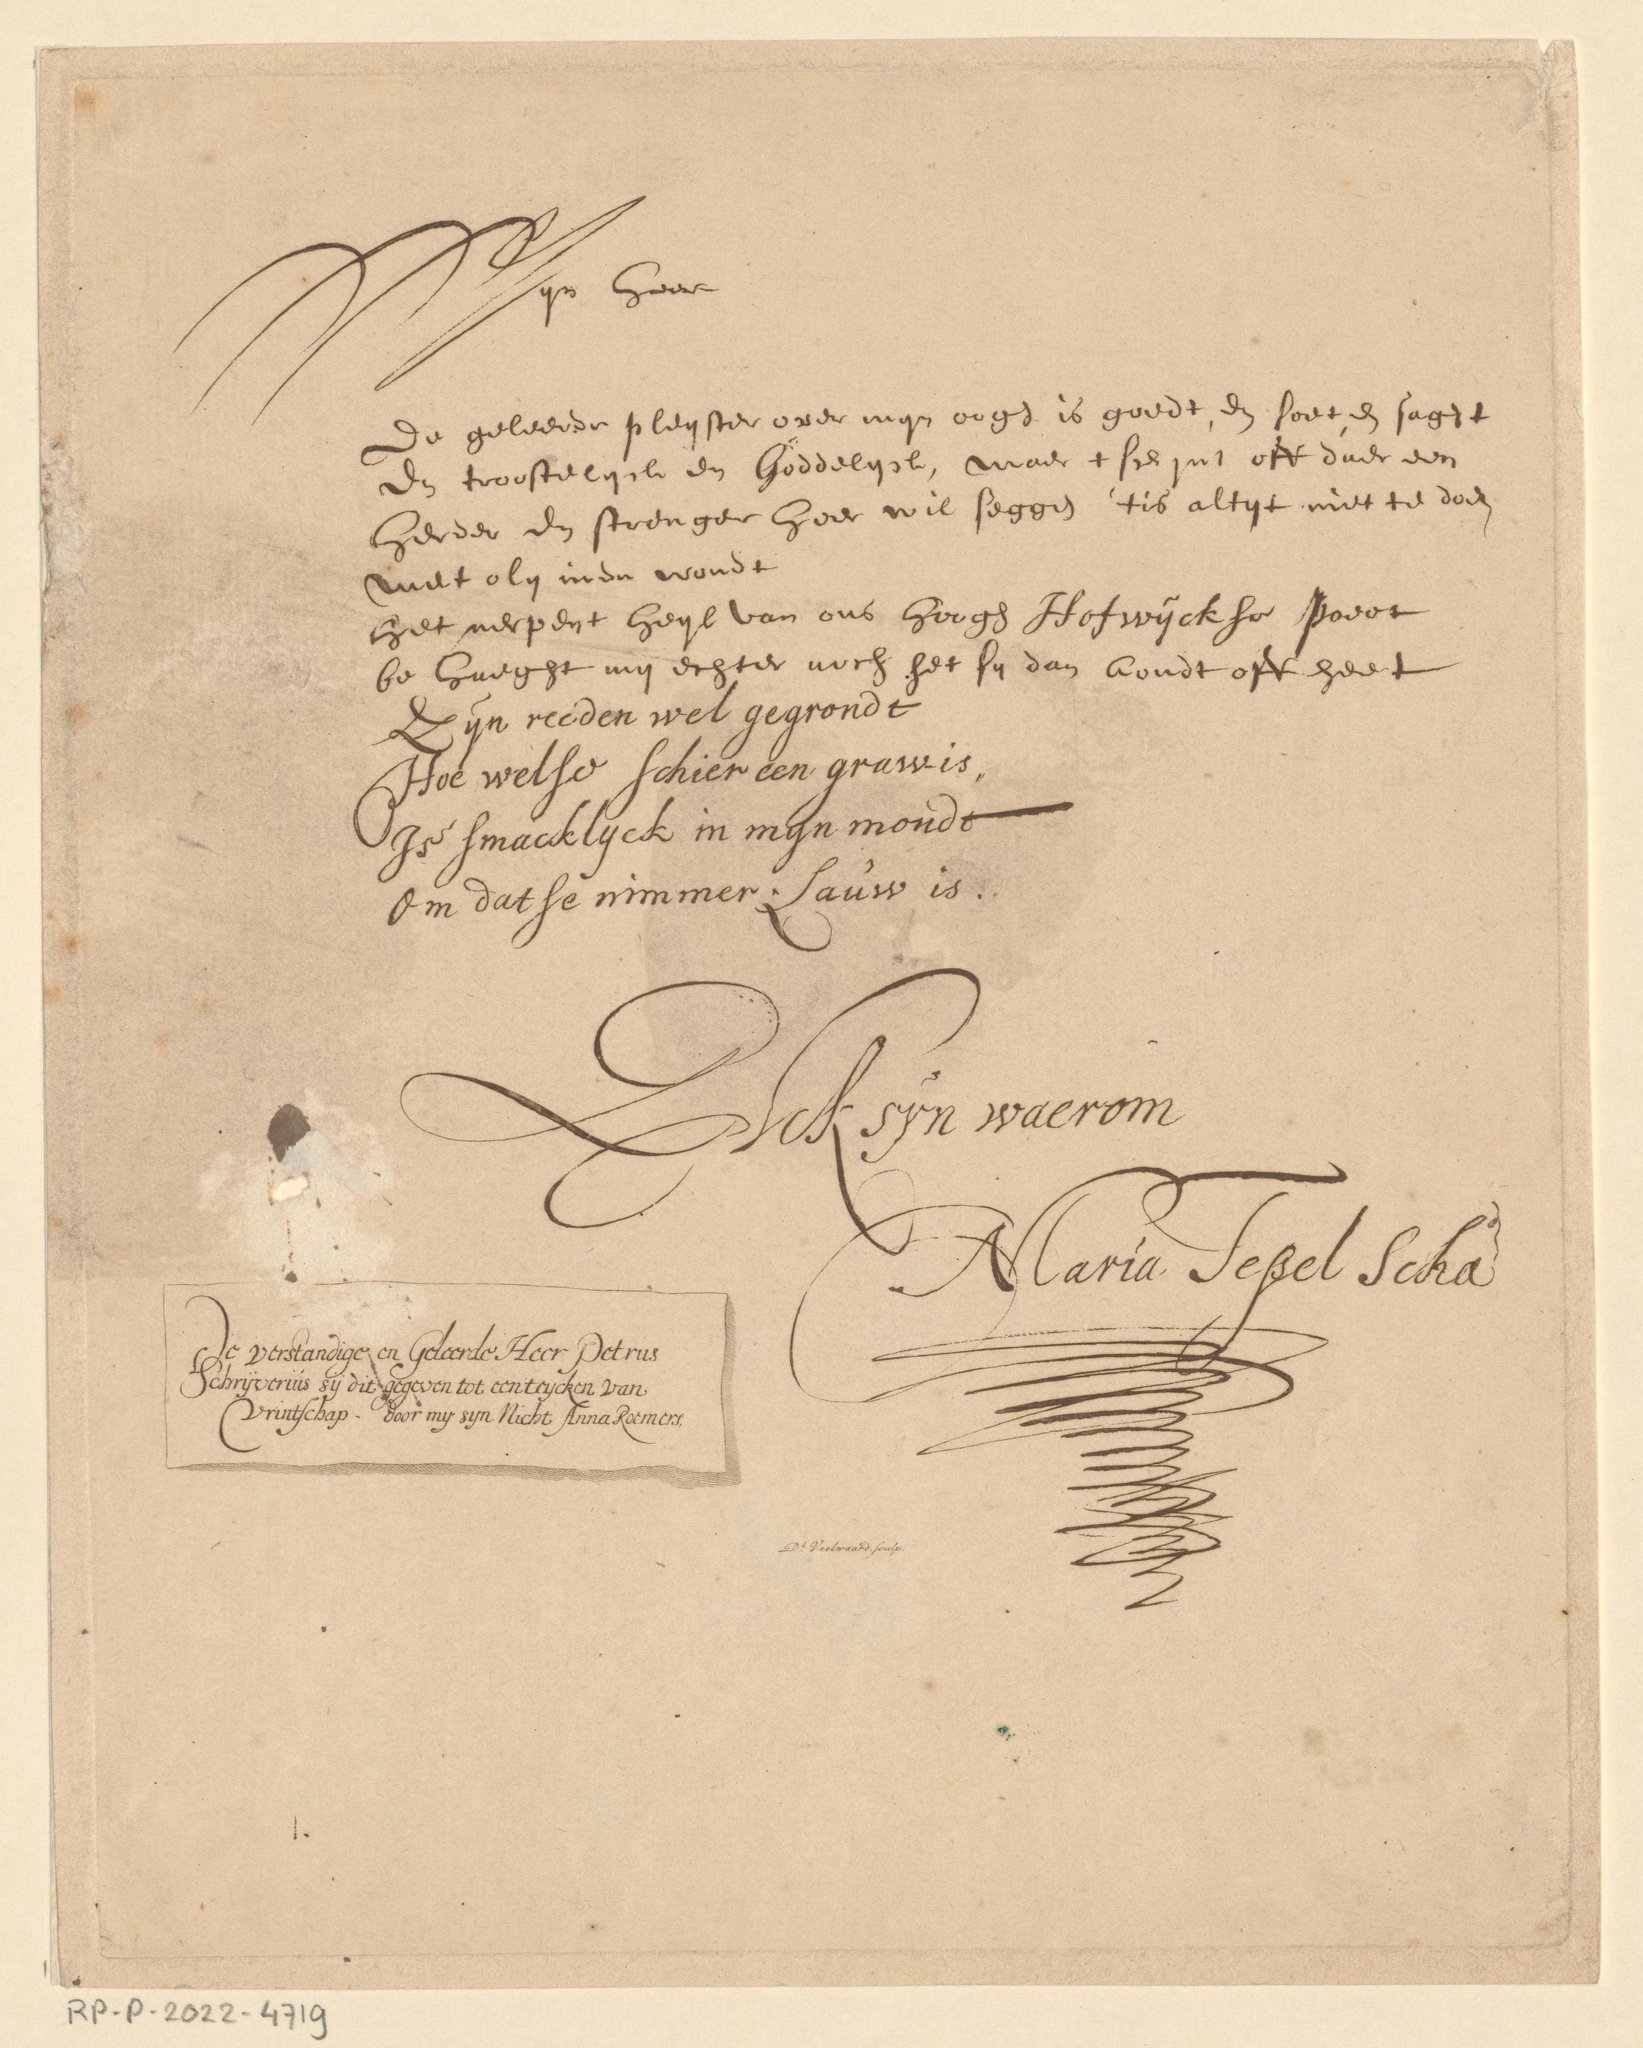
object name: print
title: Brief van Maria Tesselschade Roemers Visscher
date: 1776-1851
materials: paper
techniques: etching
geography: amsterdam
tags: amsterdam, maria tesselschade roemers visscher, handwriting, written text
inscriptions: collector's mark: Lugt 2165